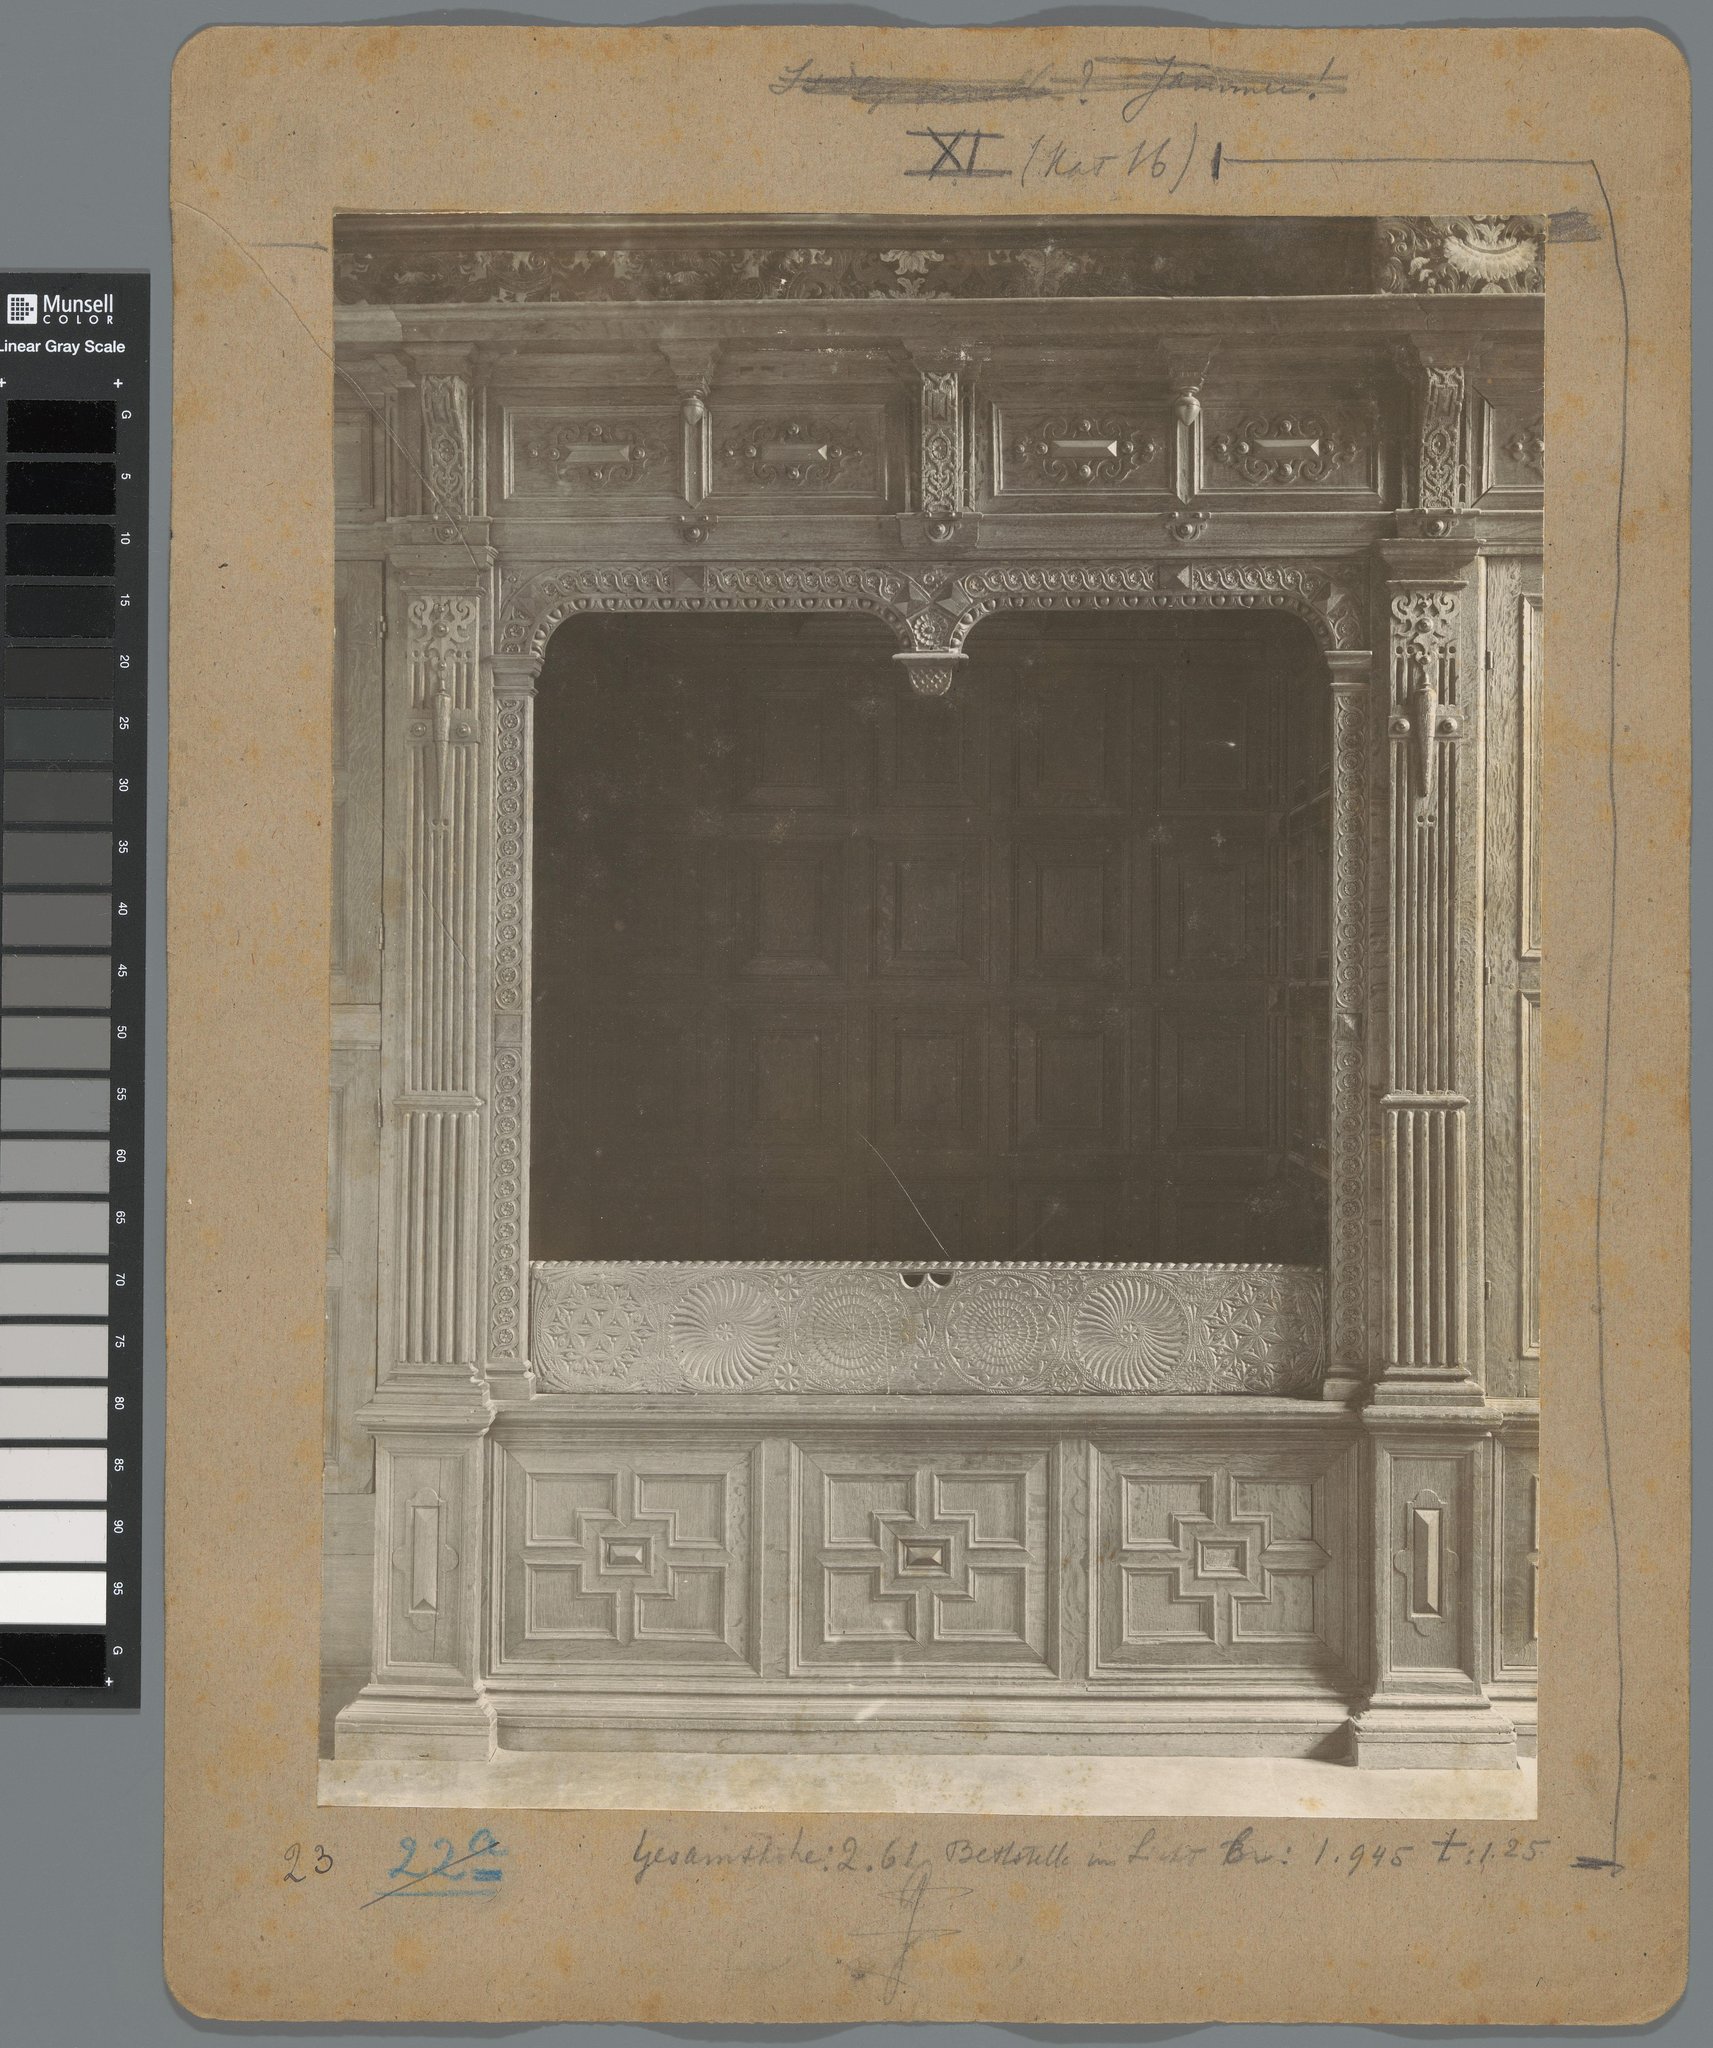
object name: photograph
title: Wandbetimmering met uitsparing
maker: Anonymous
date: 1875-1900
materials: cardboard, photographic support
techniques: gelatin silver print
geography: europe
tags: column, pillar ~ architecture, wall-covering, europe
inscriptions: collector's mark: ‘KUNSTNIJVERHEIDSCHOOL QUELLINUS AMSTERDAM FRANS HALSSTRAAT 14.’, collector's mark: ‘INSTITUUT VOOR KUNST-NIJVERHEIDSONDERWIJS GABRIËL METSUSTRAAT No. 16 AMSTERDAM’, number: ‘(Kat 16)’, number: ‘XI’, number: ‘23’